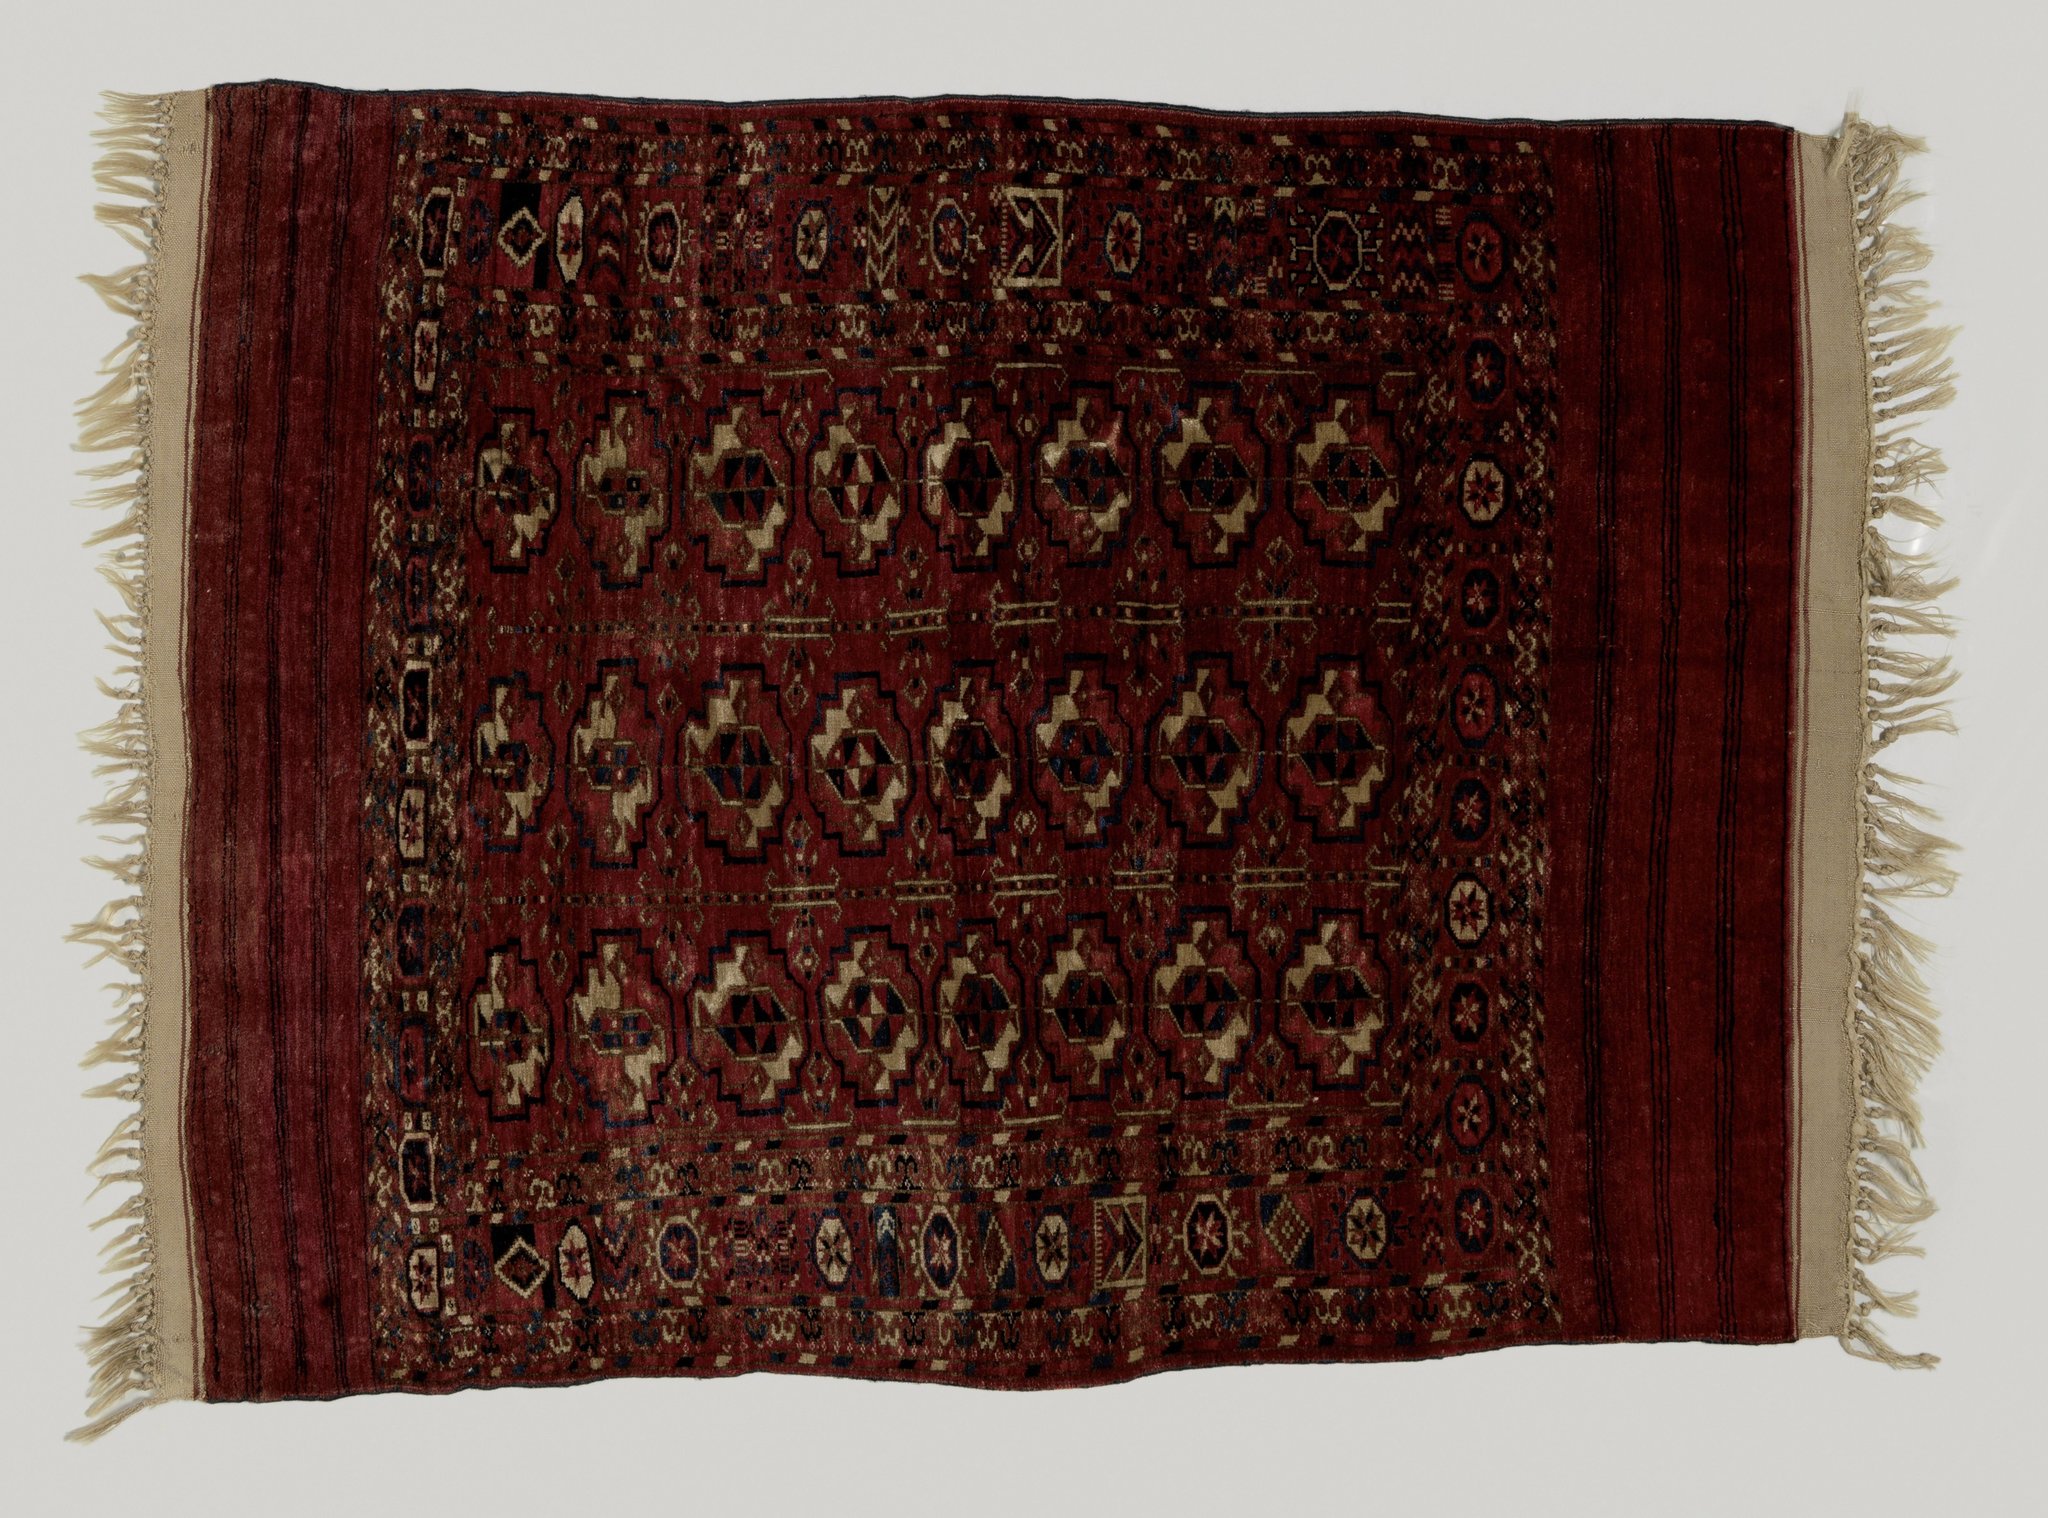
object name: tapijt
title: Oosters tapijt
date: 1875-1900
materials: wool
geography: central turkestan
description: Oosters tapijt, achthoekenkleed. In het middenveld chuval guls afgewisseld met kruisvormige motieven, z.g. chemche guls. Rand onderverdeeld in rechthoekige compartimeten met octagonale ornamenten.